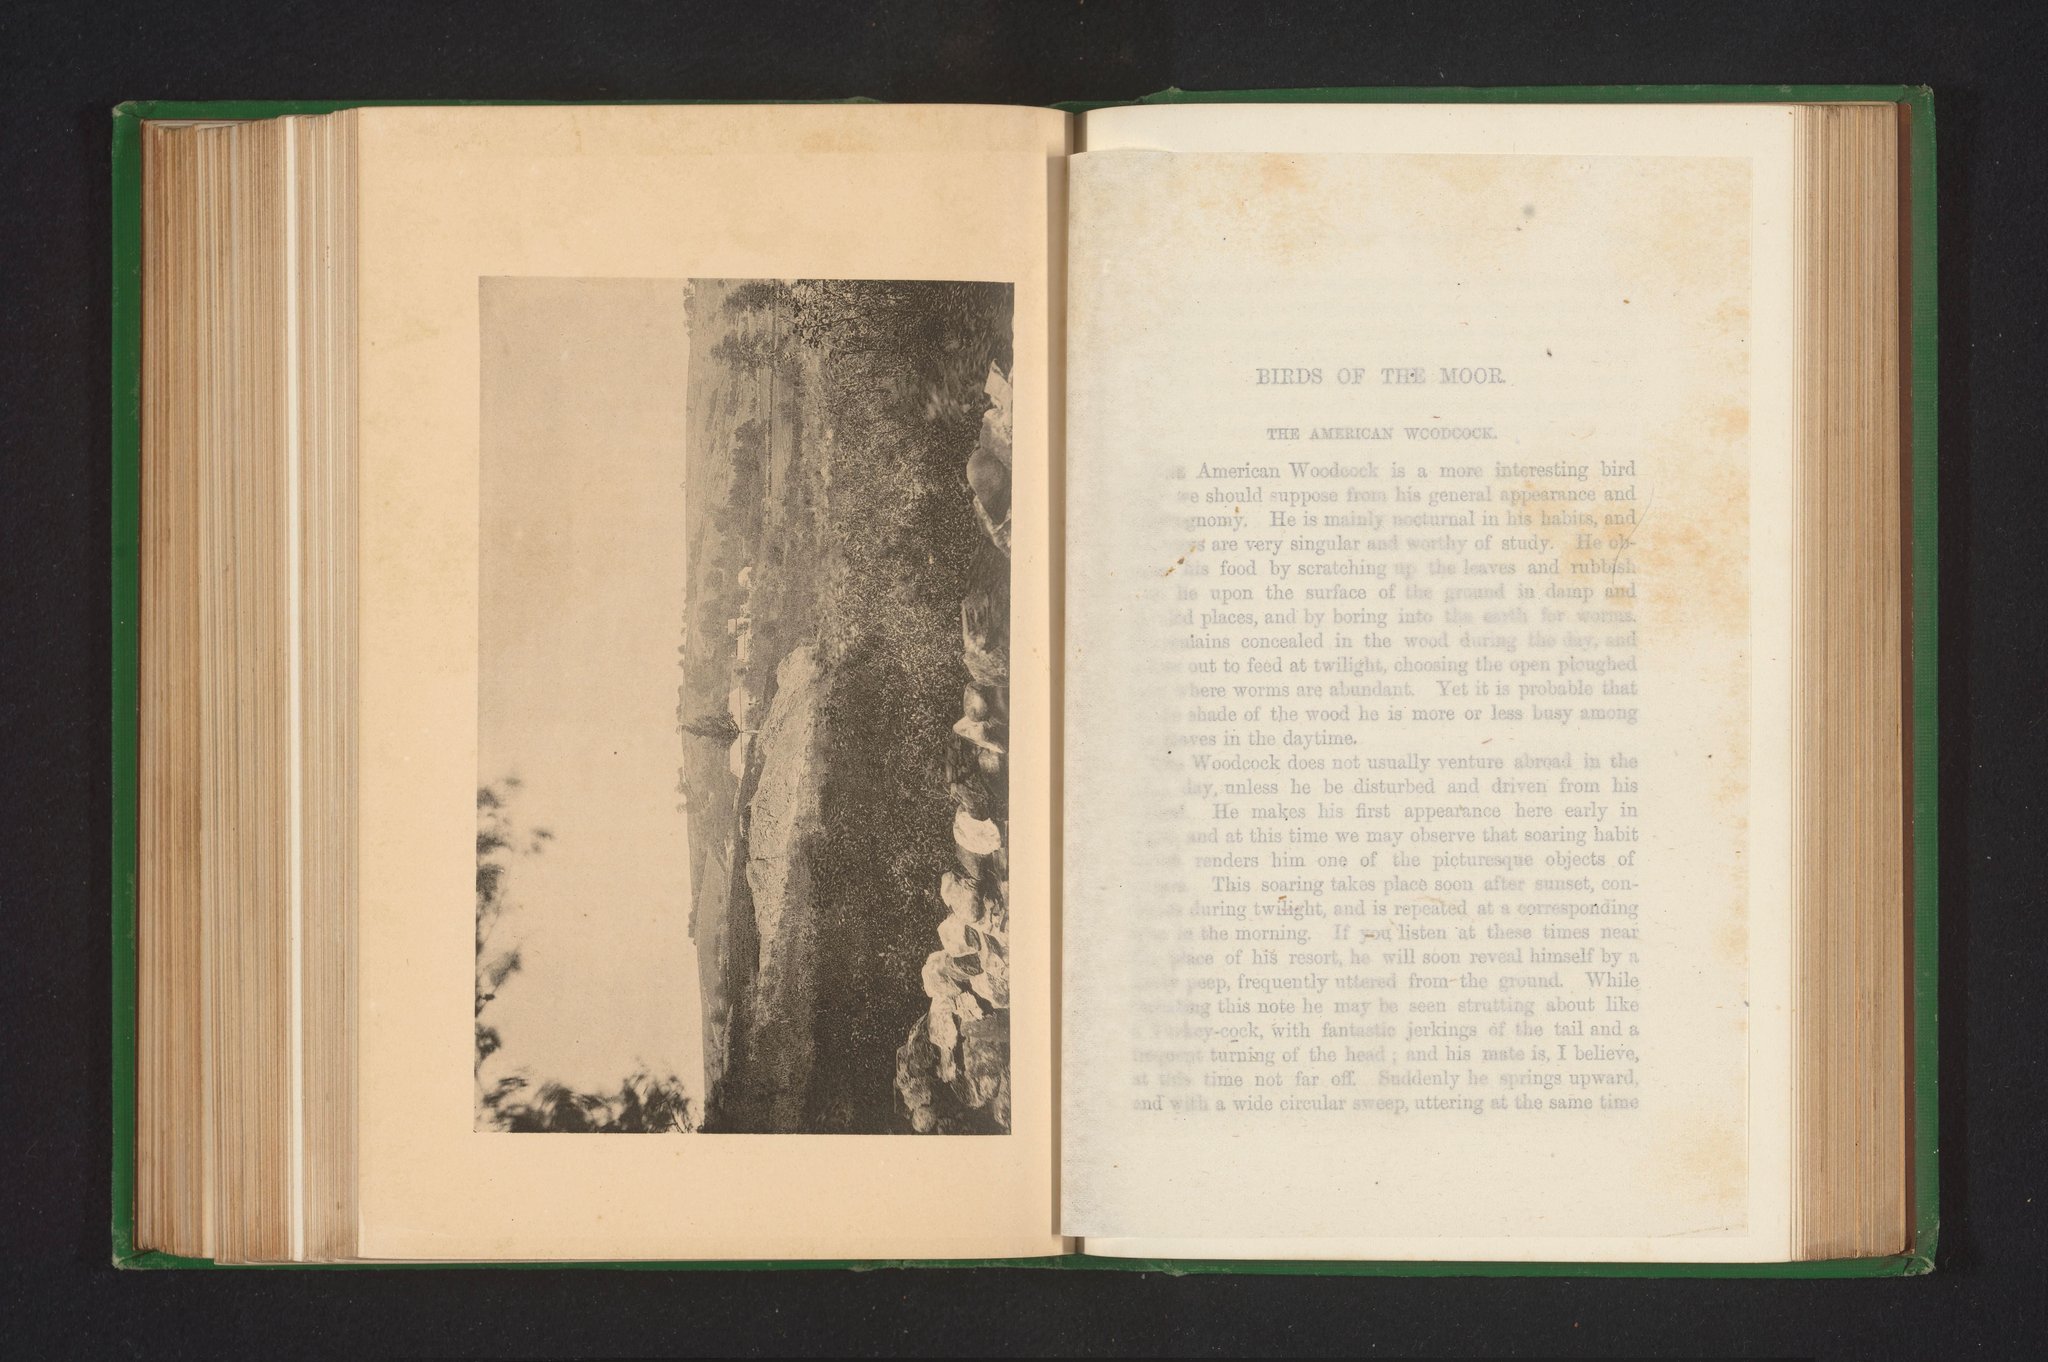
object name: photomechanical print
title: Landschap te West Boxford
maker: Anonymous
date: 1875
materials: paper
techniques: photograph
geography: west boxford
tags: landscapes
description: Prent op tweede ongenummerde pagina na pagina 332.